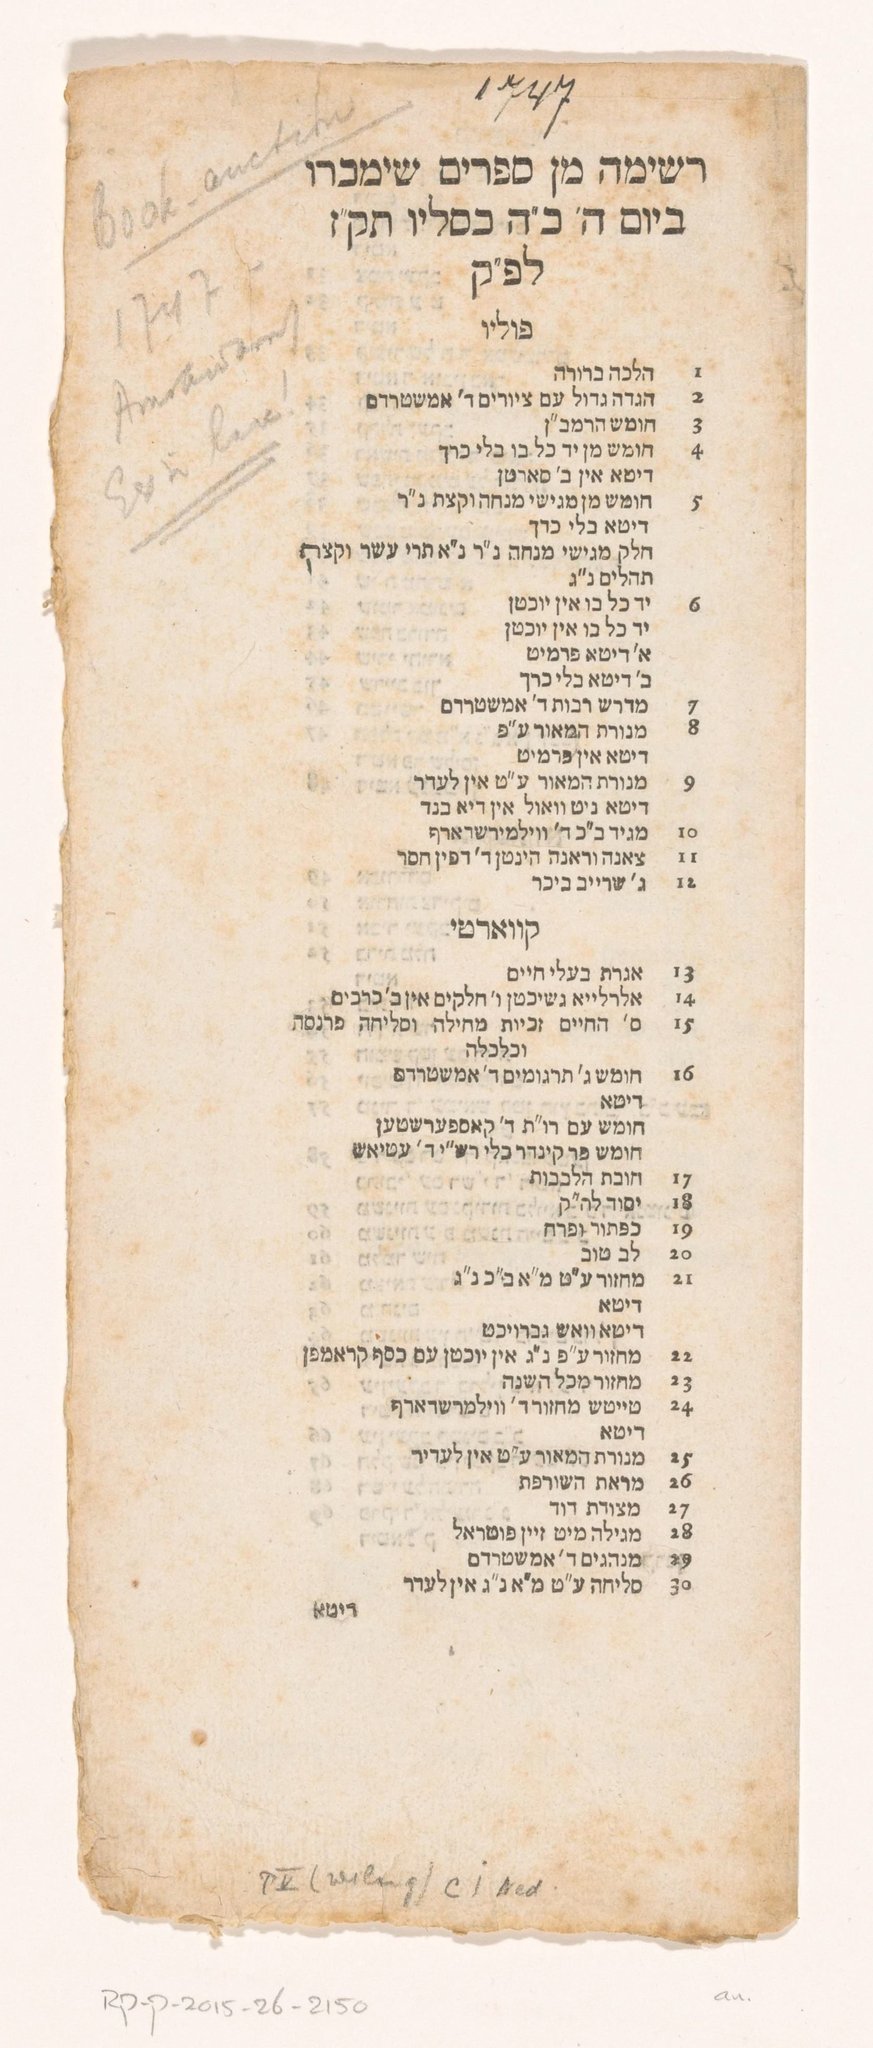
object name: print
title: Veilingcatalogus met Hebreeuwse boeken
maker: Anonymous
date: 1747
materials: paper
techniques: letterpress printing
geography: amsterdam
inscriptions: collector's mark: ‘Doublet Gemeente Archief Amsterdam’, collector's mark: Lugt 4780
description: Veilingcatalogus bestaand uit een dubbelgevouwen blad met drie pagina's tekst. Waarschijnlijk betreft het een veiling met Hebreeuwse boeken, geveild in Amsterdam in 1747.